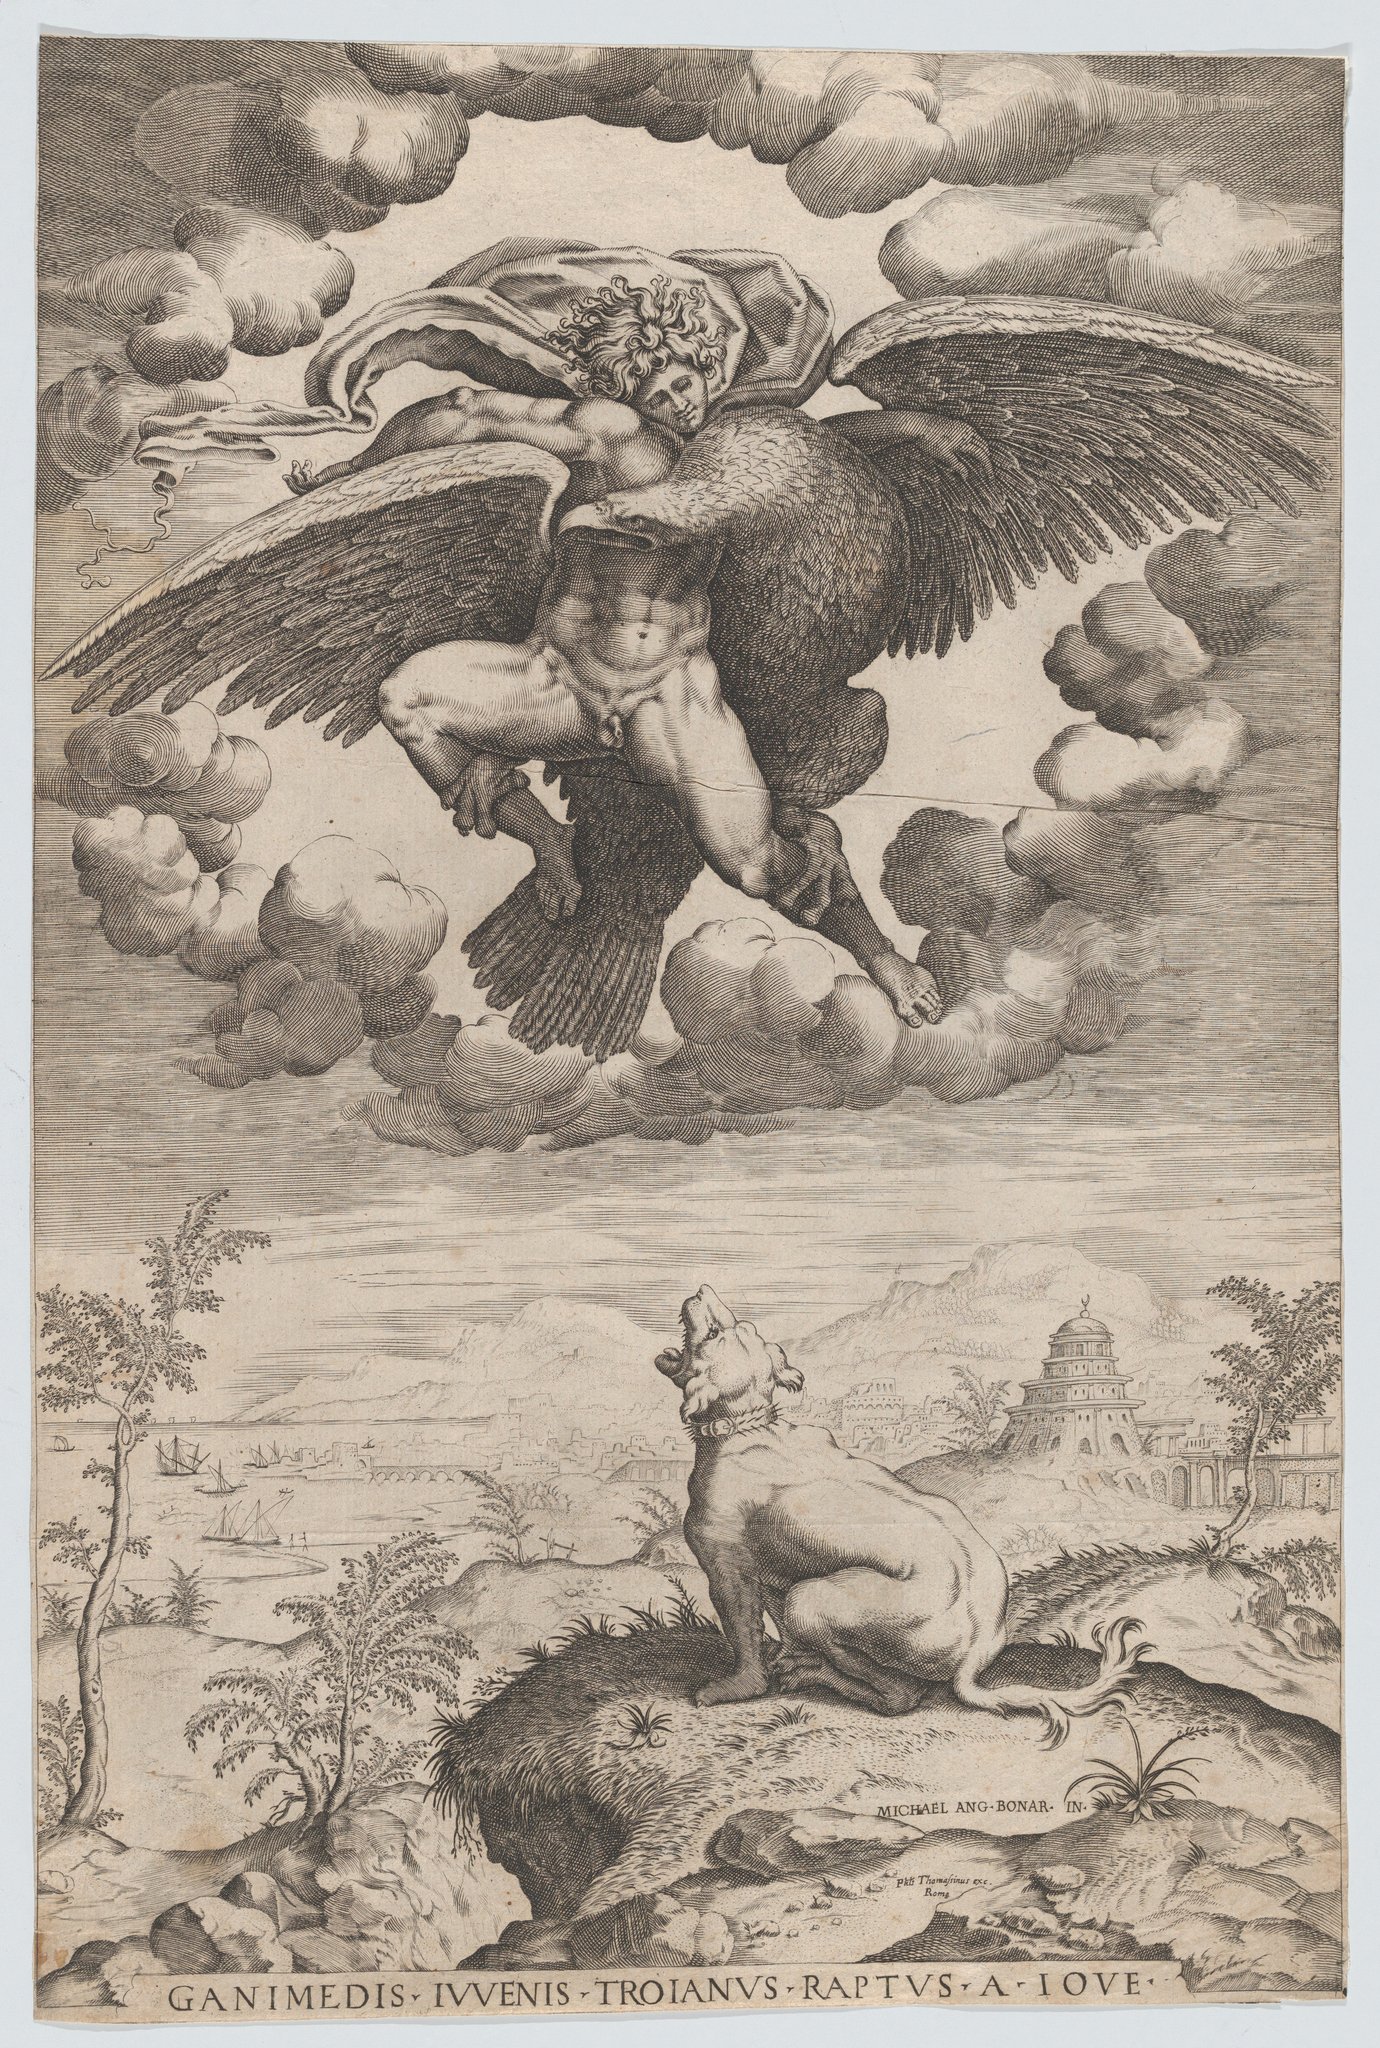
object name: print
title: The Rape of Ganymede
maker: Anonymous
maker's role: artist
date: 1542-1560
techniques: engraving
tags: eagles,male nudes,dogs